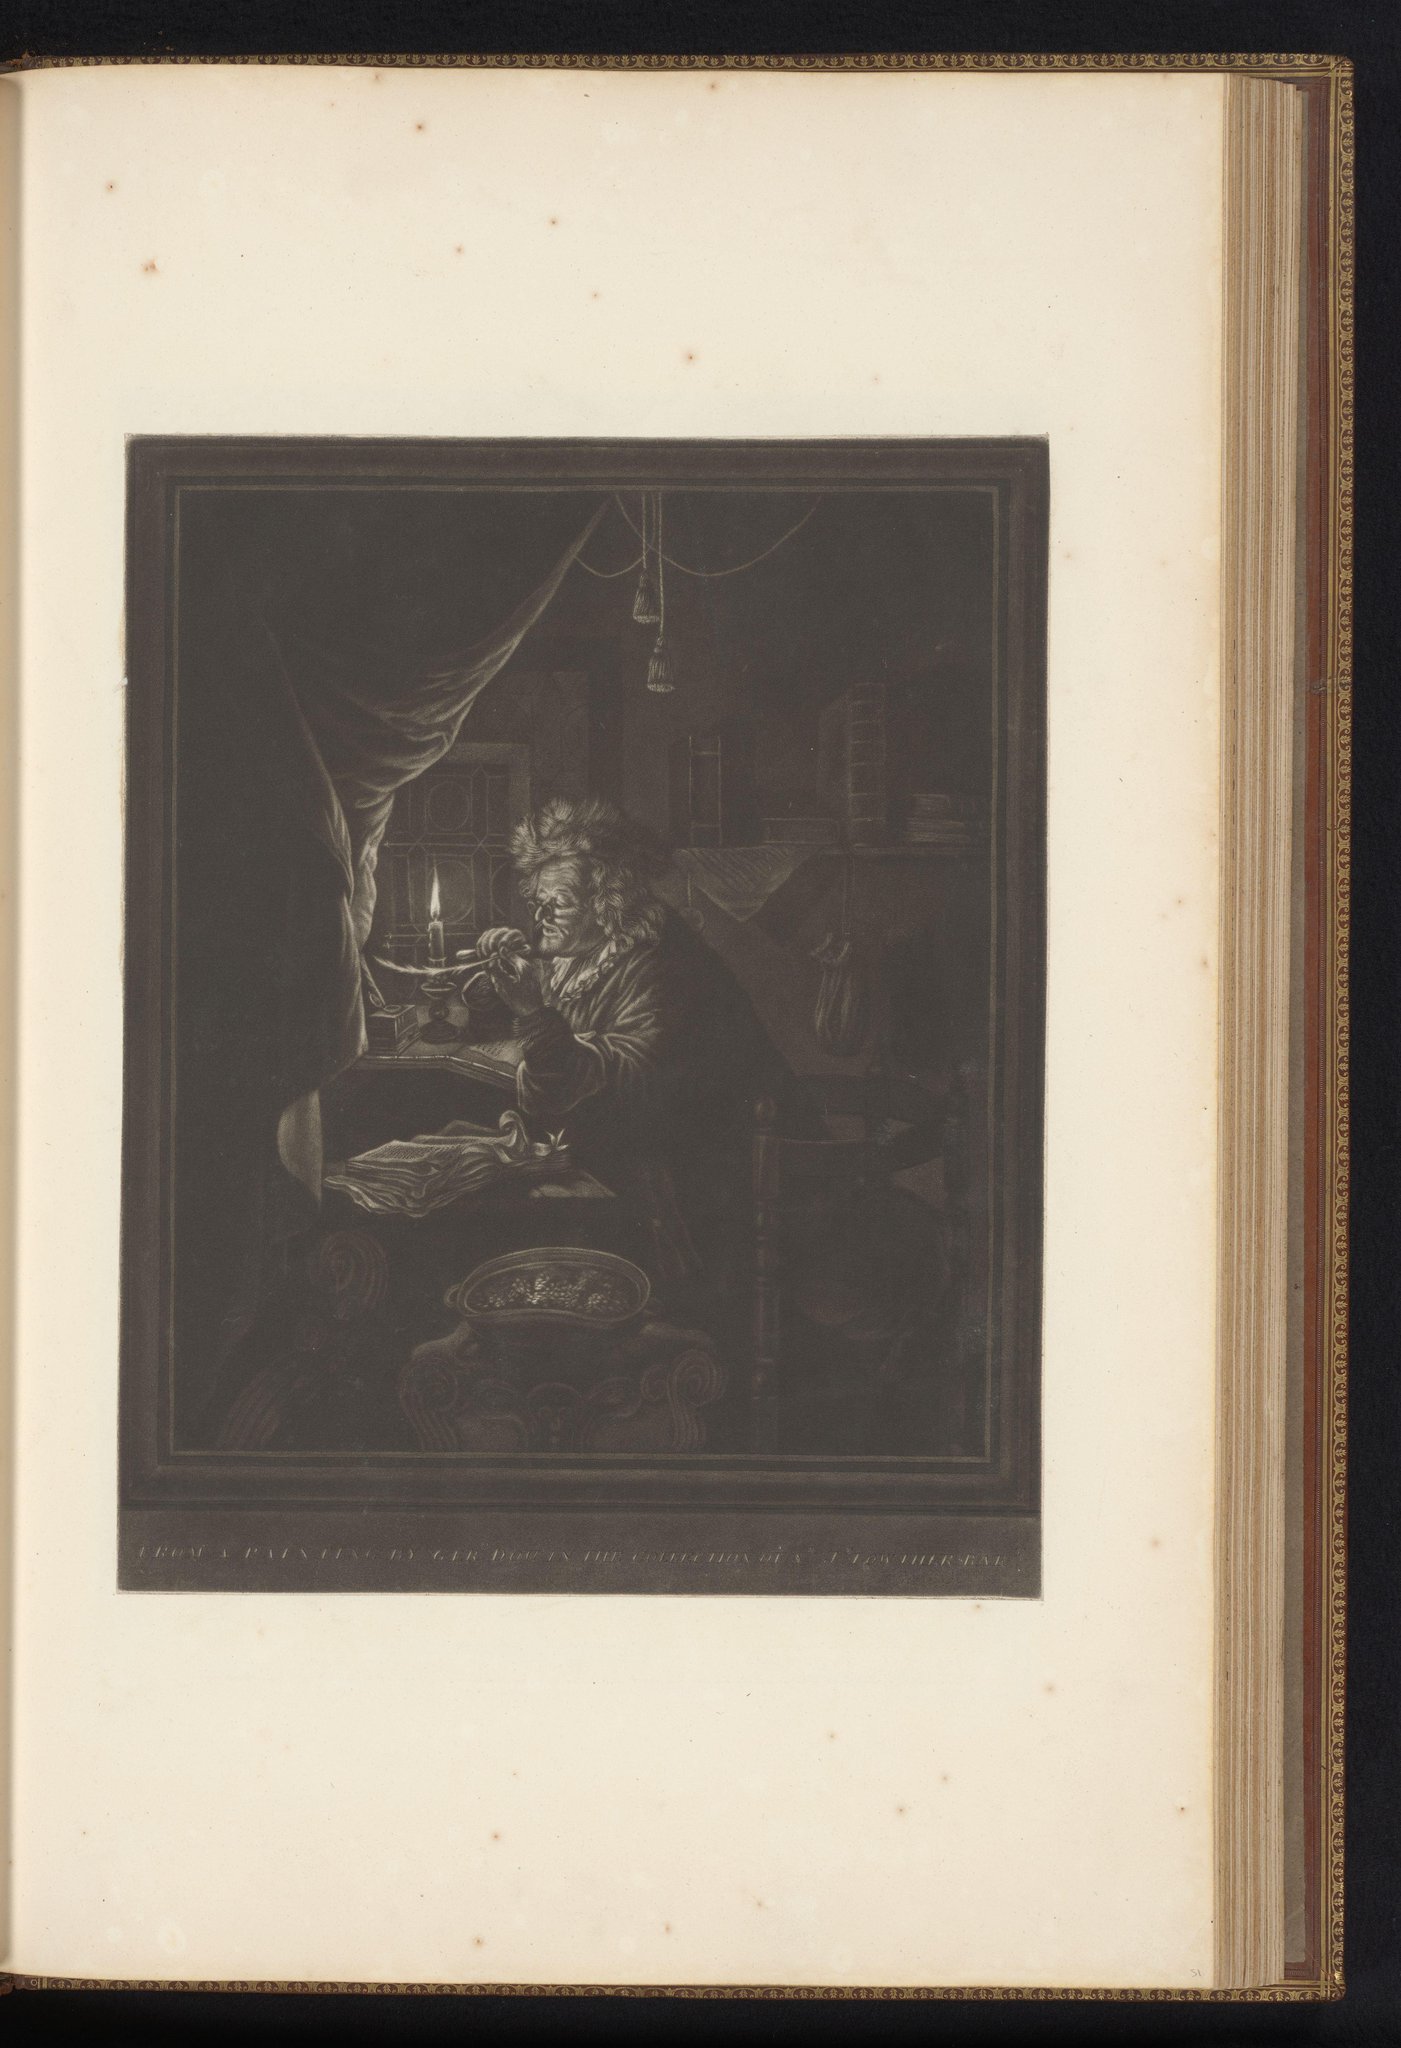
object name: print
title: Pensnijder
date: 1753-1810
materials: paper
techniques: mezzotint, pasting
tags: pen, book, studying at night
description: Een oude man met bontmuts en bril werkt voorovergebogen aan een tafel. Hij snijdt een ganzenveer bij het licht van een kaars. De prent maakt deel uit van een album.